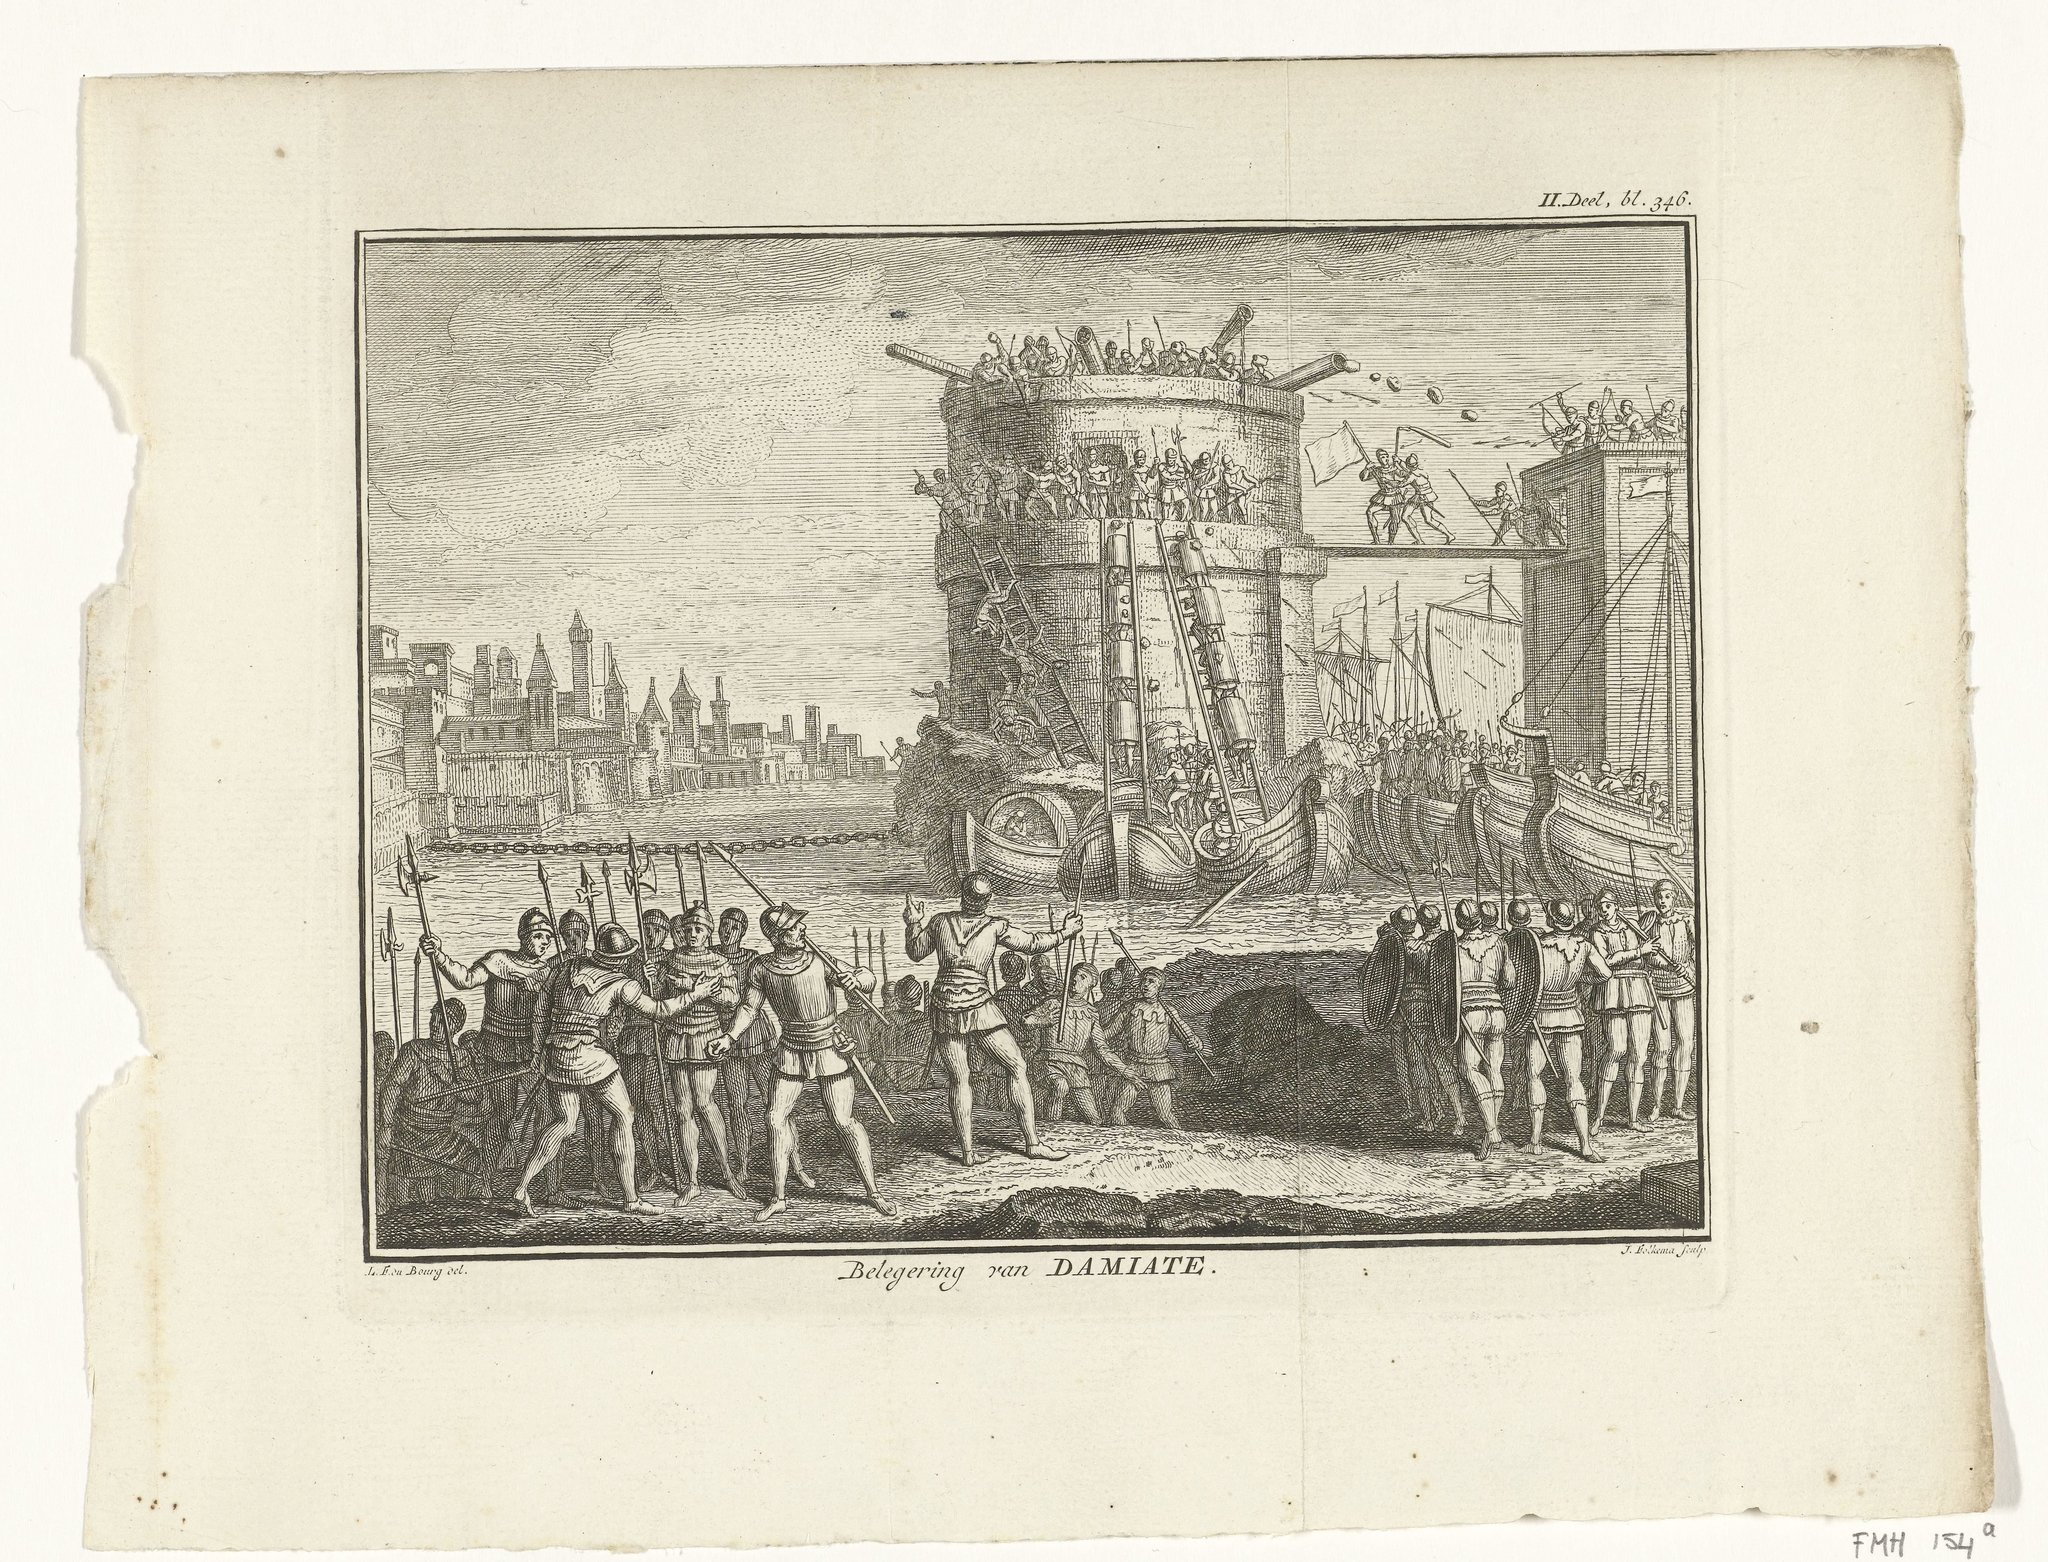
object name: print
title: Beleg van Damiate, 1219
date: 1749-1759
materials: paper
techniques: etching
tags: siege, position war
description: Het beleg van de stad Damiate, 1219. De toren, gelegen aan een met ketting afgesloten haven, wordt aangevallen door soldaten die met schepen zijn aangevoerd. Prent rechtsboven gemerkt: II. Deel, bl. 346.